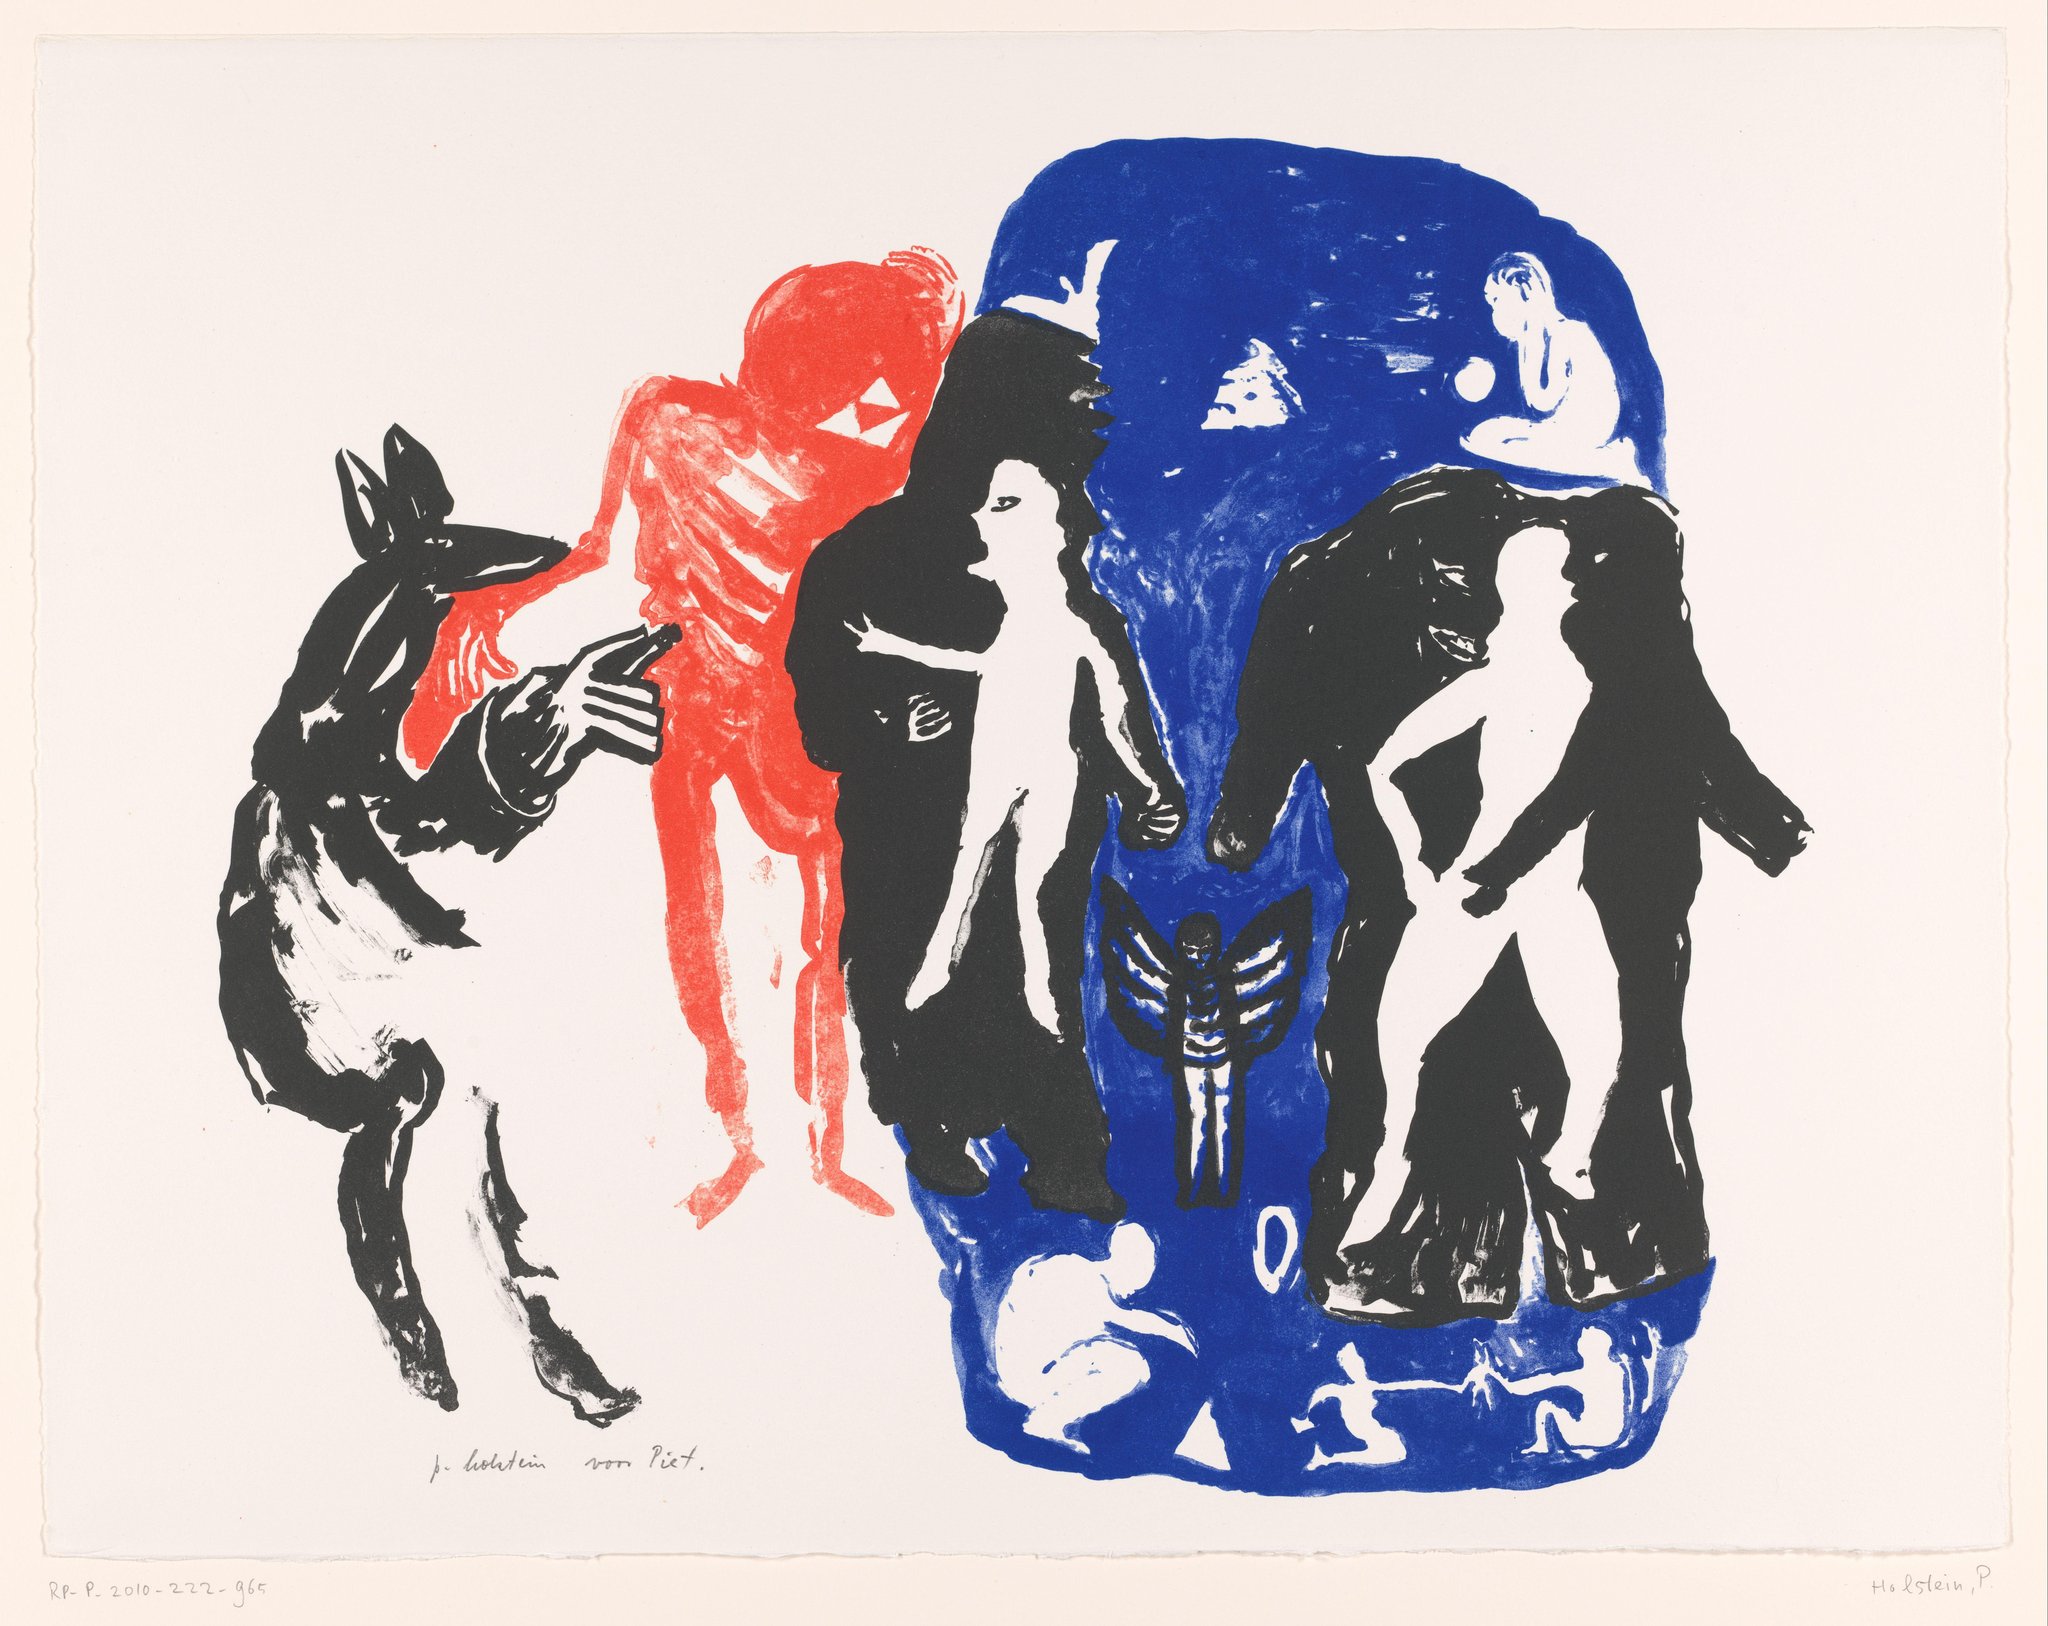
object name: print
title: Wolf en mensen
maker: pieter holstein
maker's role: draughtsman, painter, print maker, sculptor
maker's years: 1934-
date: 1957-2009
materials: paper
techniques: lithograph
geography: amsterdam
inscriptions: inscription: ‘voor Piet’, signature: ‘p. holstein’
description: Links een wolf en rechts een aantal mensen die met zwart zijn opgezet en een aantal die gedefinieerd worden door een uitsparing (wit) binnen de omtrek van de donkere figuren.